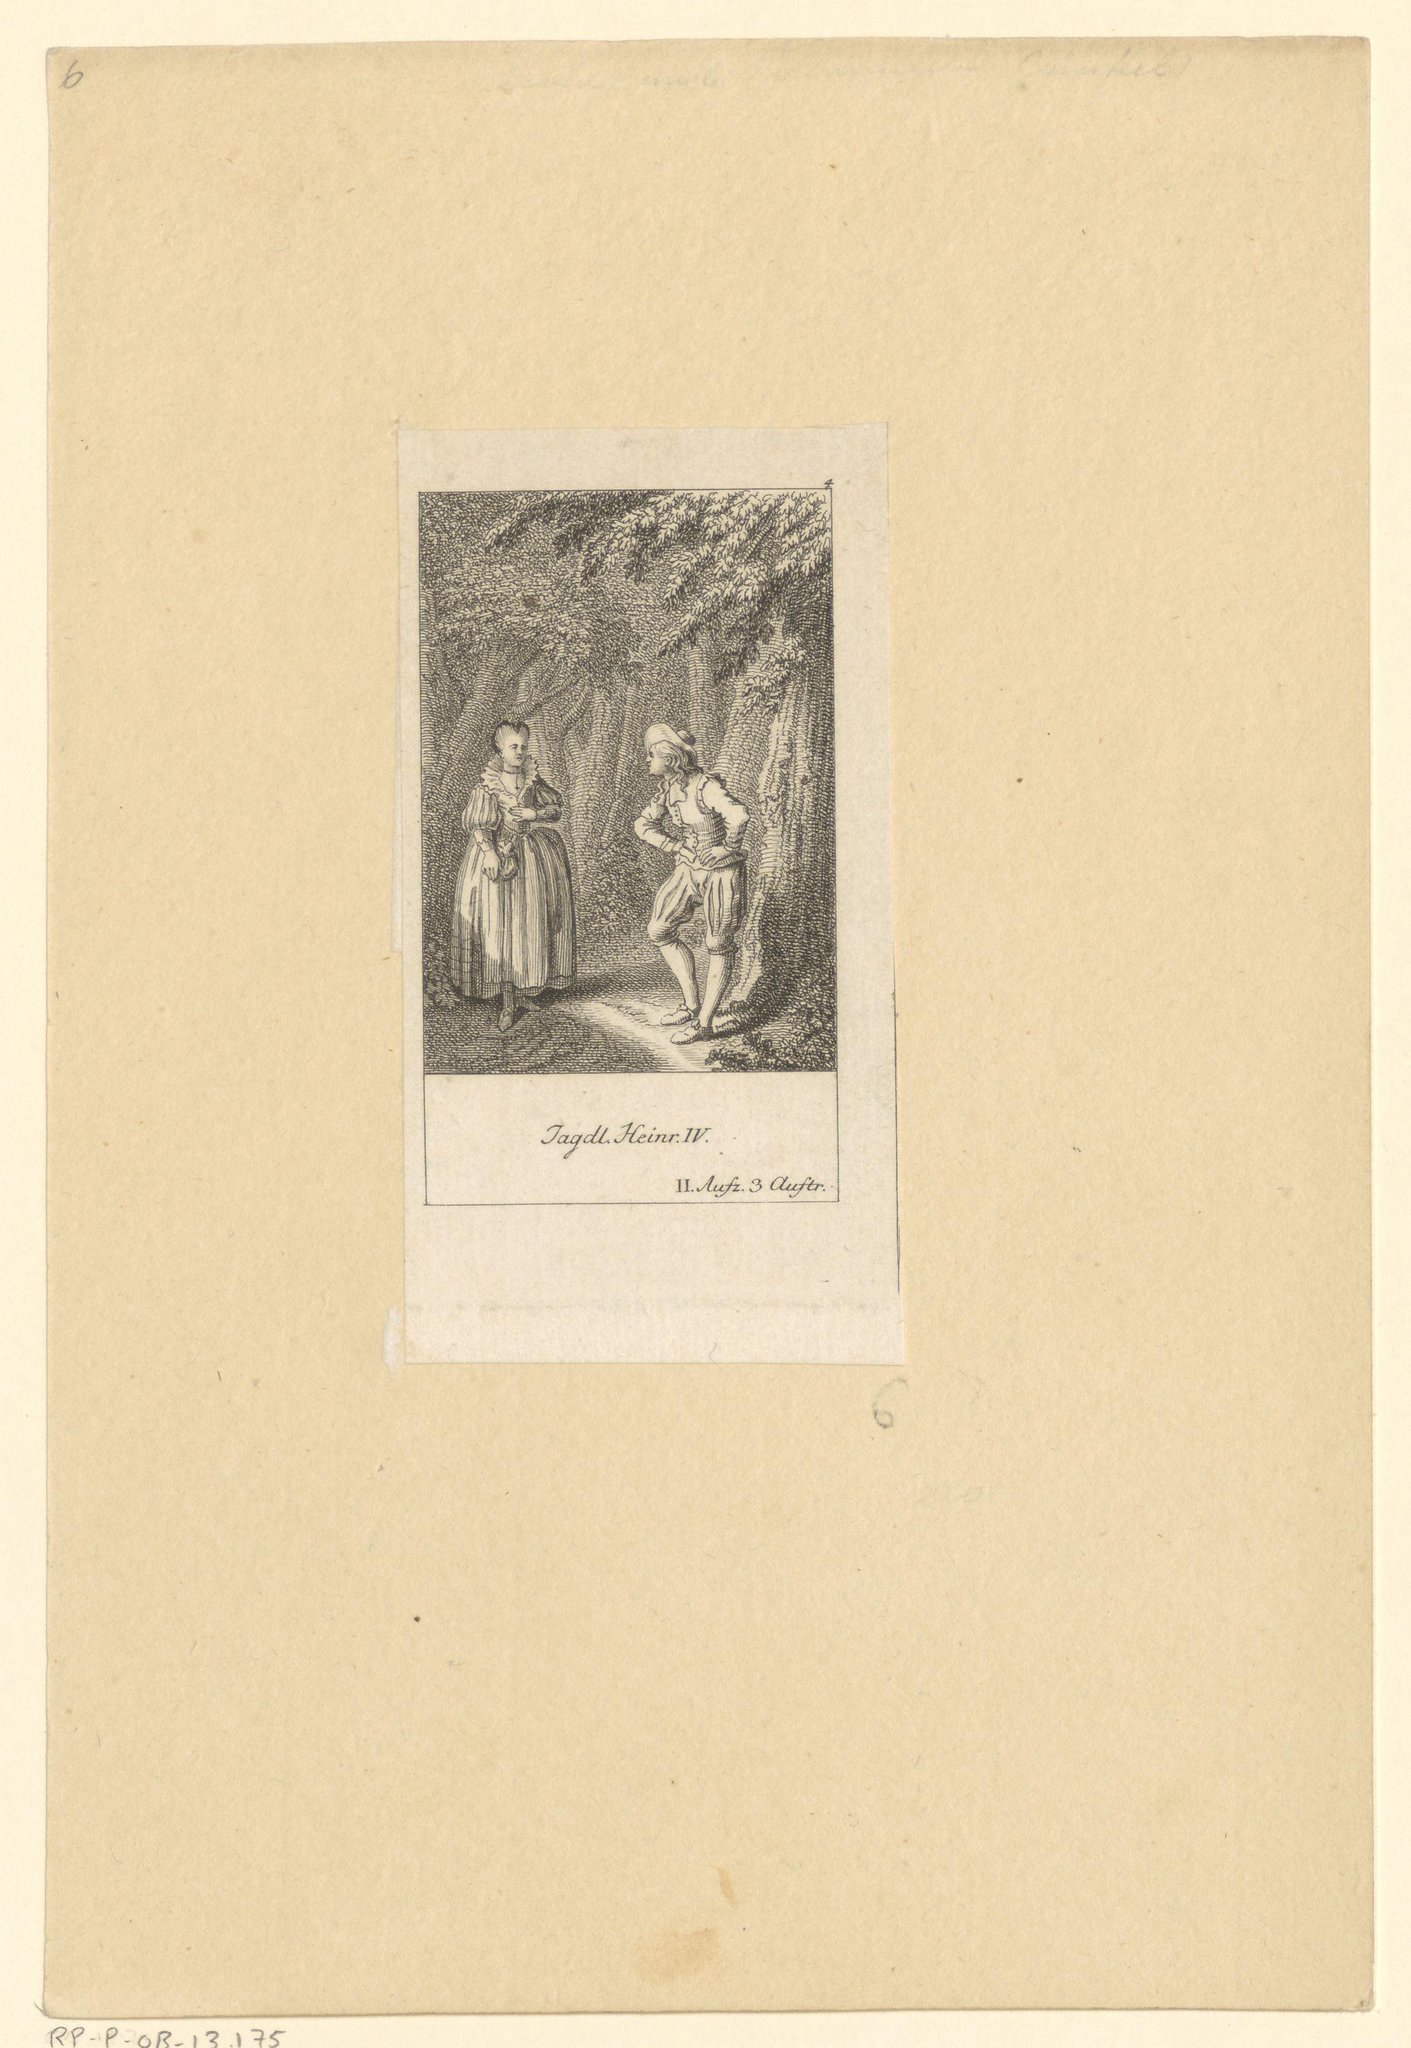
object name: print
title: Lucas en Agathe in het bos van Sénart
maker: daniel berger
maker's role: print maker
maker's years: 1744-1824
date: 1774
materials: paper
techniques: etching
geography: berlin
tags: hendrik iv (koning van frankrijk en navarra), literary characters and objects, forest, wood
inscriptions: collector's mark: Lugt 2228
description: Prent afkomstig uit: Genealogischen Calender für West-Preussen auf das Jahr 1775, uitgegeven op kosten van de Konigliche Academie der Wissenschaften. Deze prent maakt deel uit van een serie van twaalf prenten, gedrukt van een koperplaat. De prenten tonen scènes uit het toneelstuk 'La partie de chasse de Henri IV' (1767) van Charles Collé.